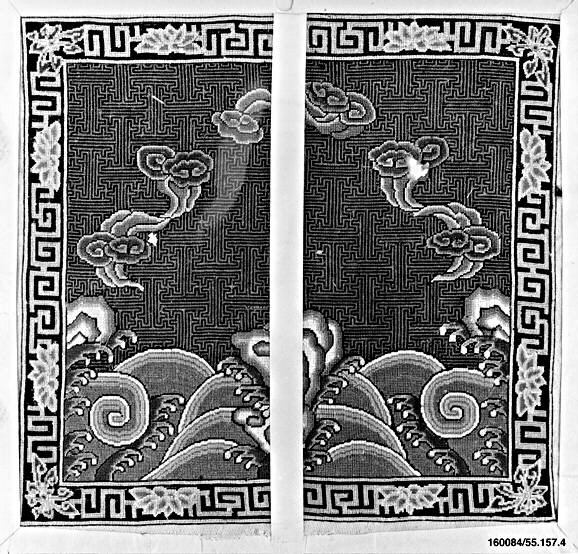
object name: rank badge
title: Rank Badge with Waves and Rocks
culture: chinese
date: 1867-1933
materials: metal thread, silk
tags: waves